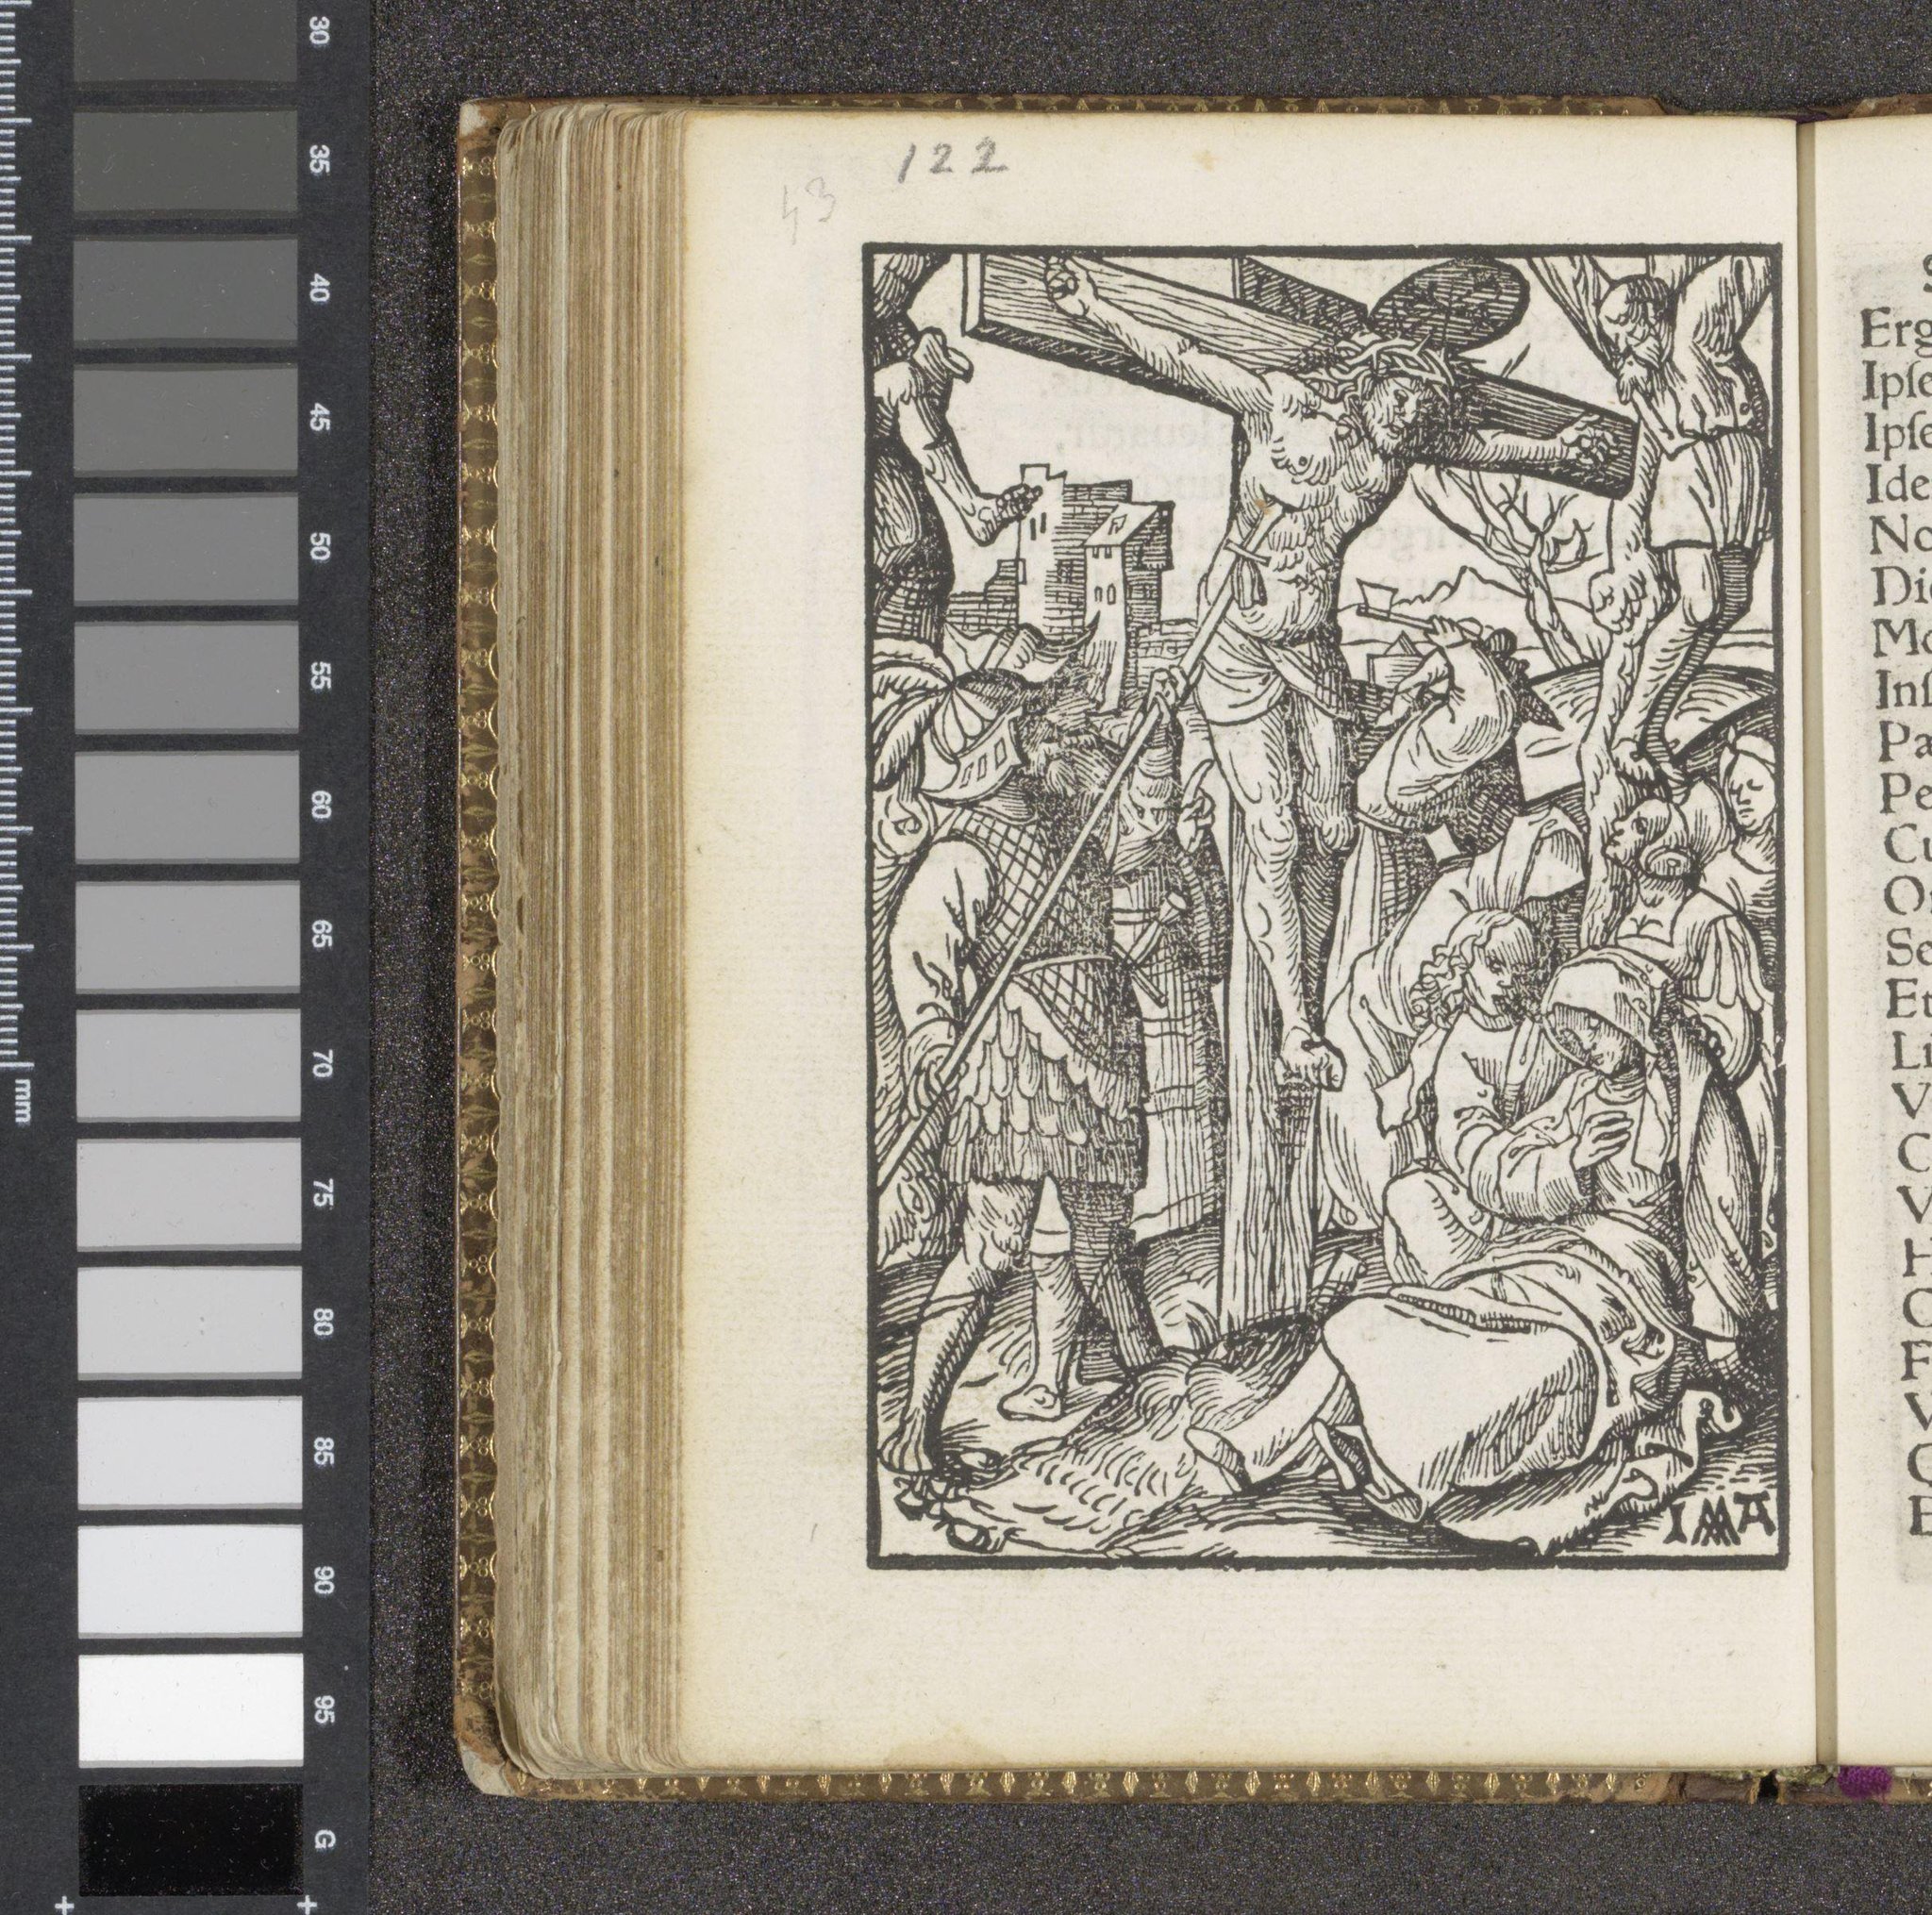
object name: print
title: De kleine Passie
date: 1523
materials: paper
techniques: woodcut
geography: amsterdam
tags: crucified christ with mary, john, and mary magdalene, longinus pierces christ's side with a lance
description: Christus hangt aan het het kruis tussen de kruisen van twee misdadigers. De soldaat Longinus steekt een lans in Christus zij. Johannes en Maria zitten onder het kruis. Prent maakt deel uit van een boek.